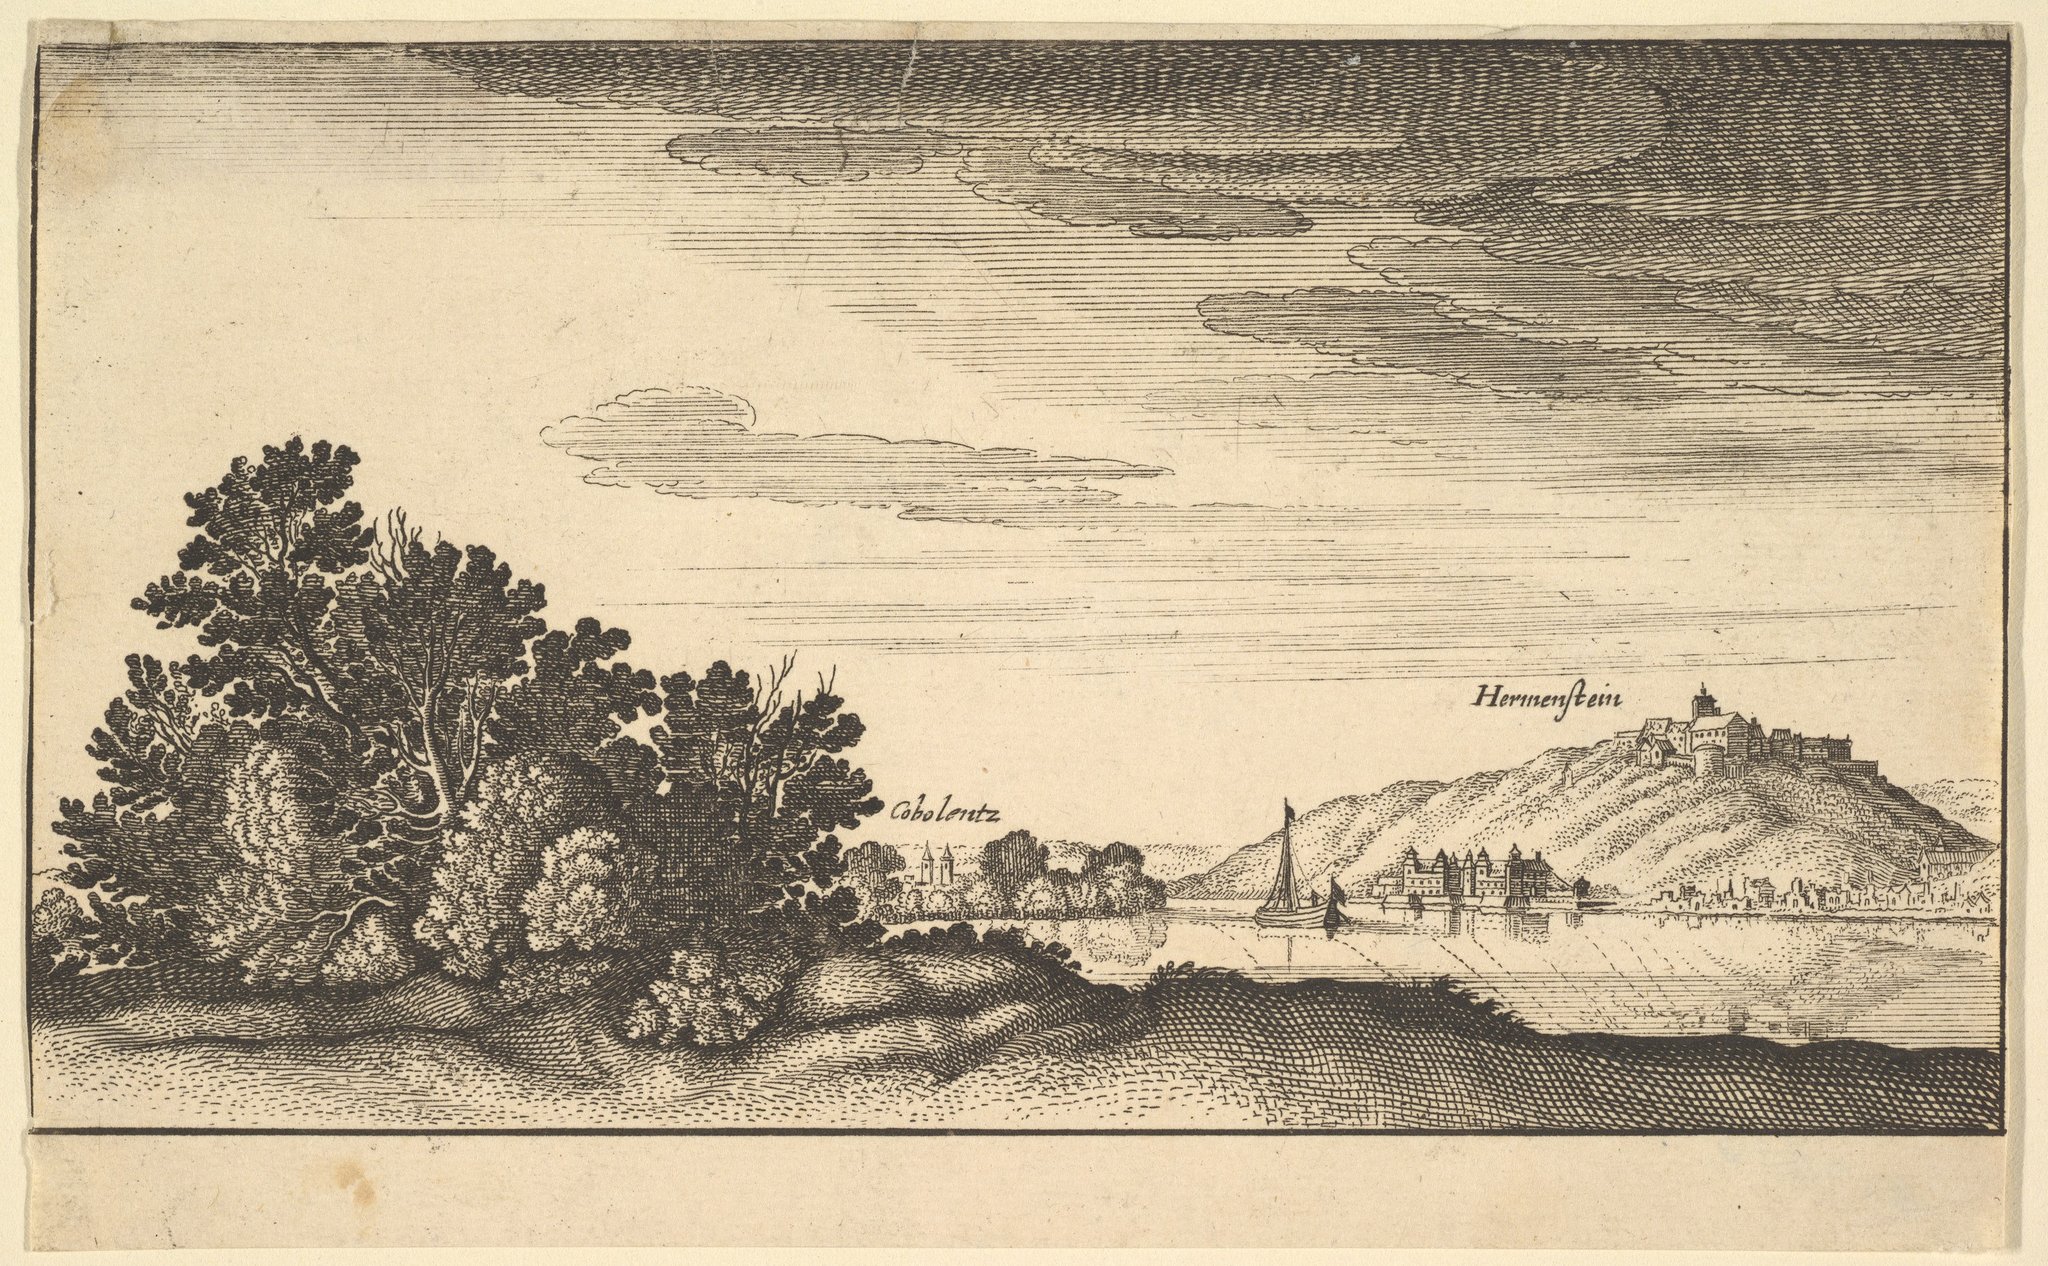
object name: print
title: Coblentz and Harmenstein [copy]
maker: abraham aubri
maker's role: etcher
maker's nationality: french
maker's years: 1607-1677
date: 1664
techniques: etching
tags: landscapes,trees